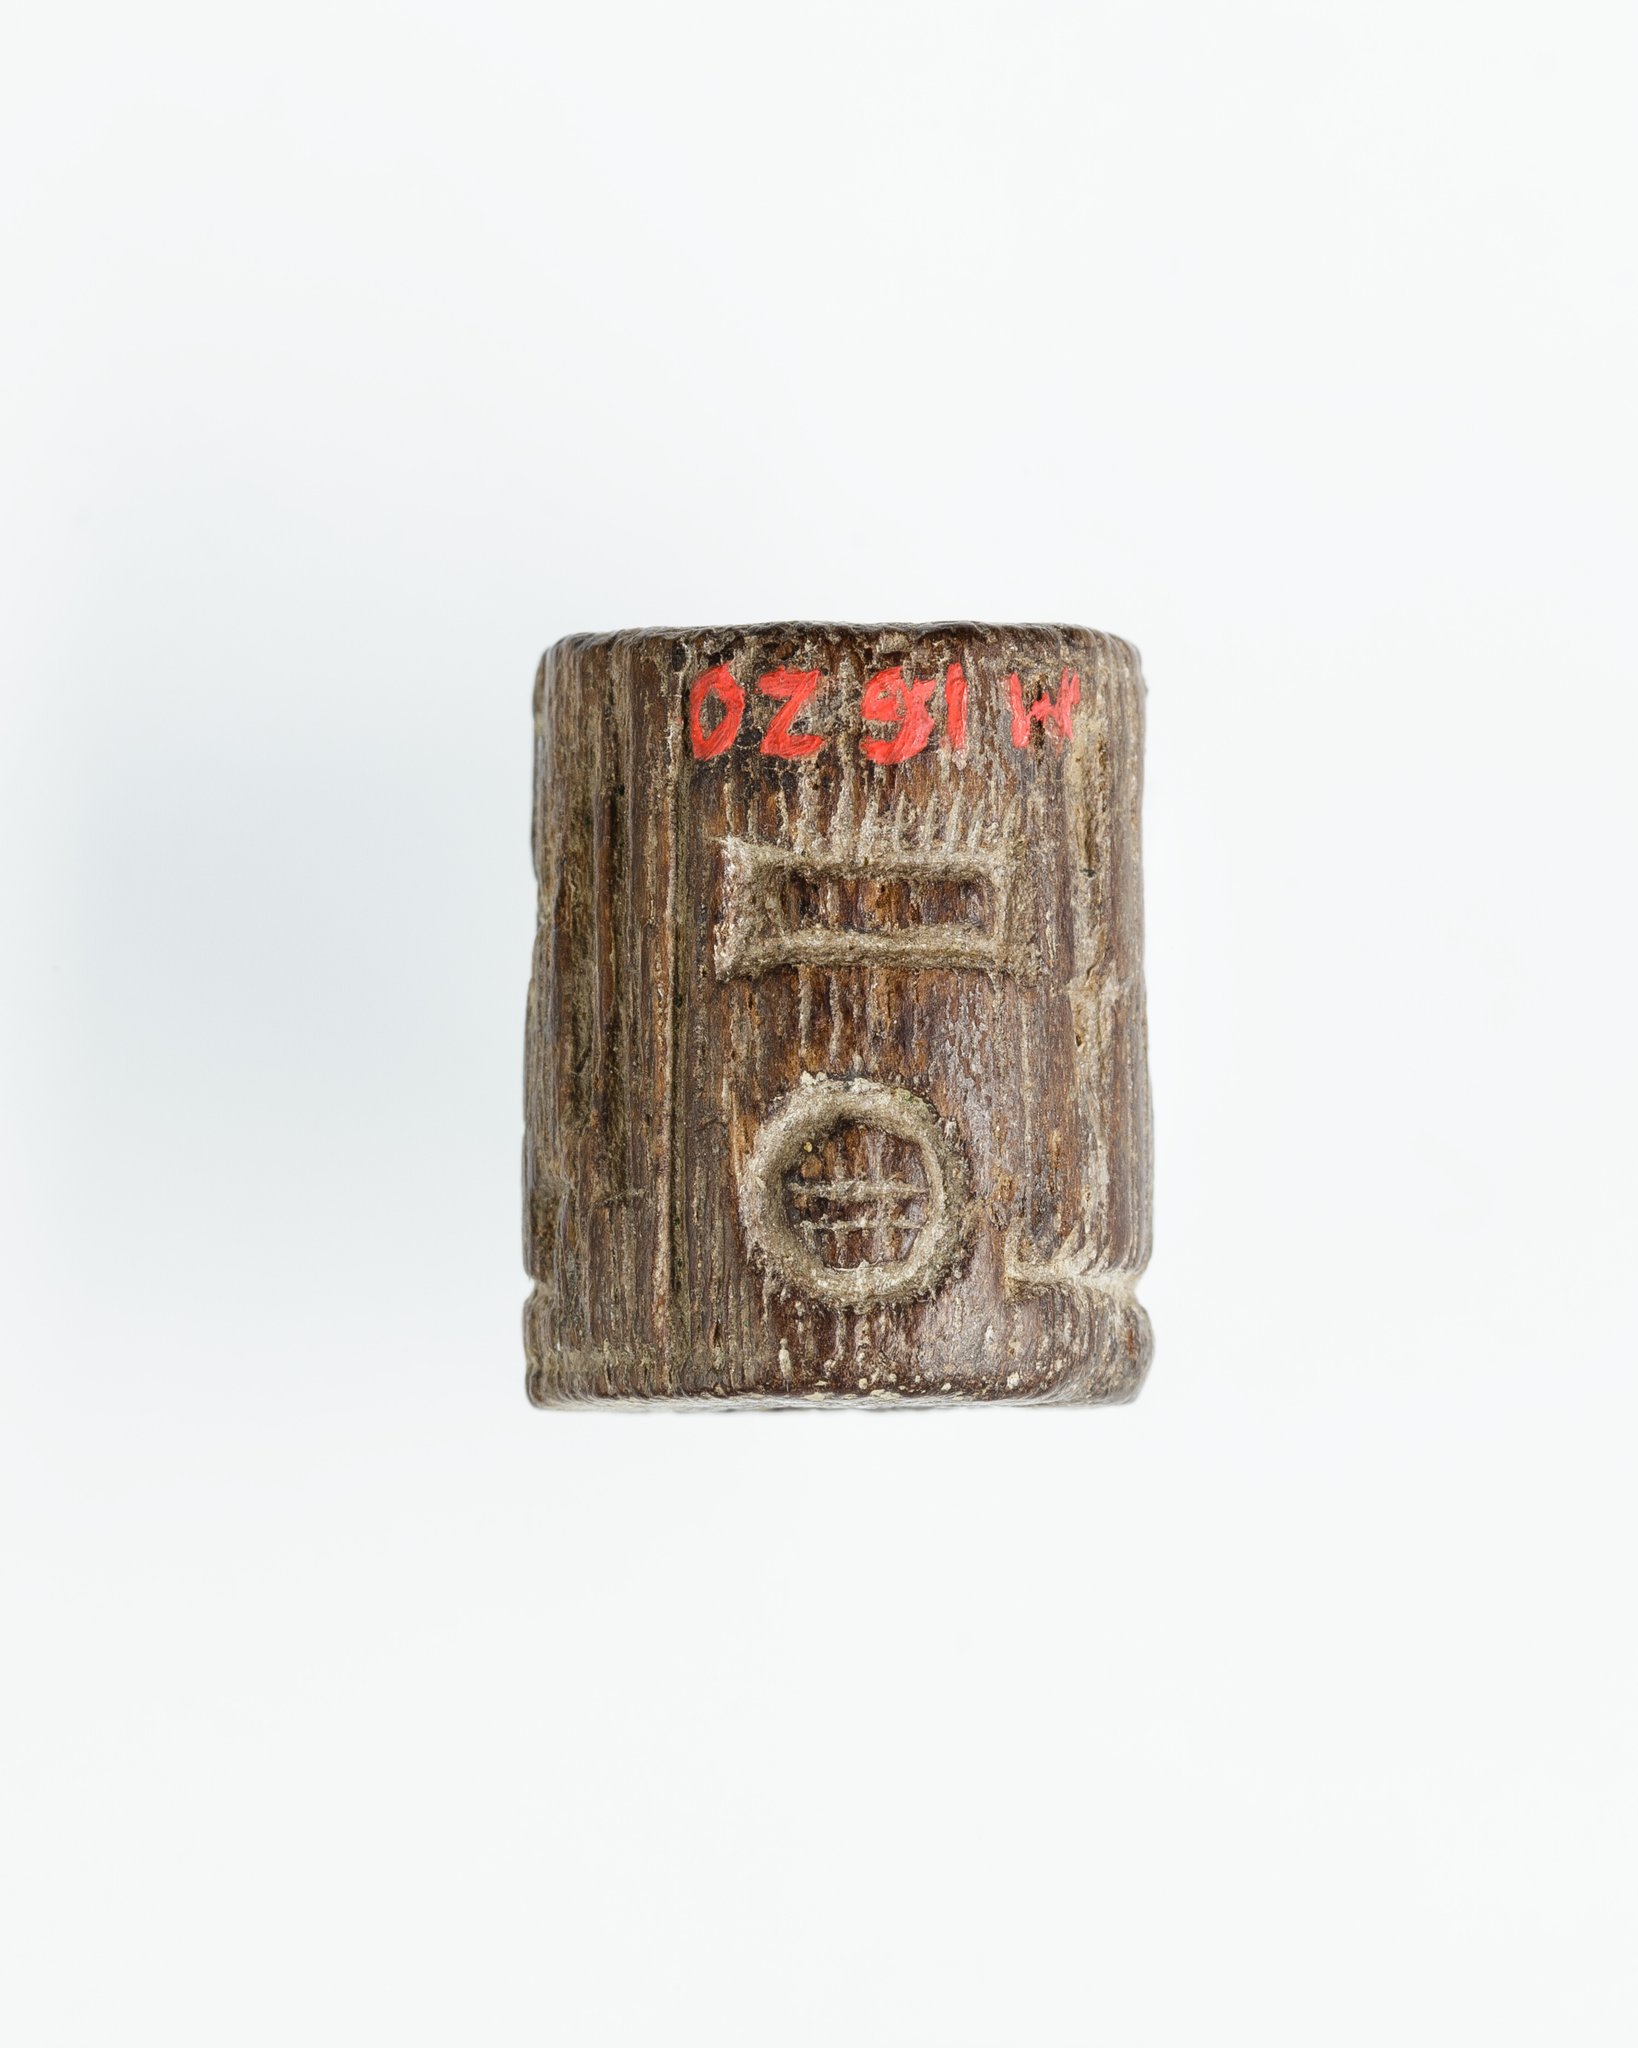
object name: cylinder seal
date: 2960-2649 BCE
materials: wood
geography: egypt